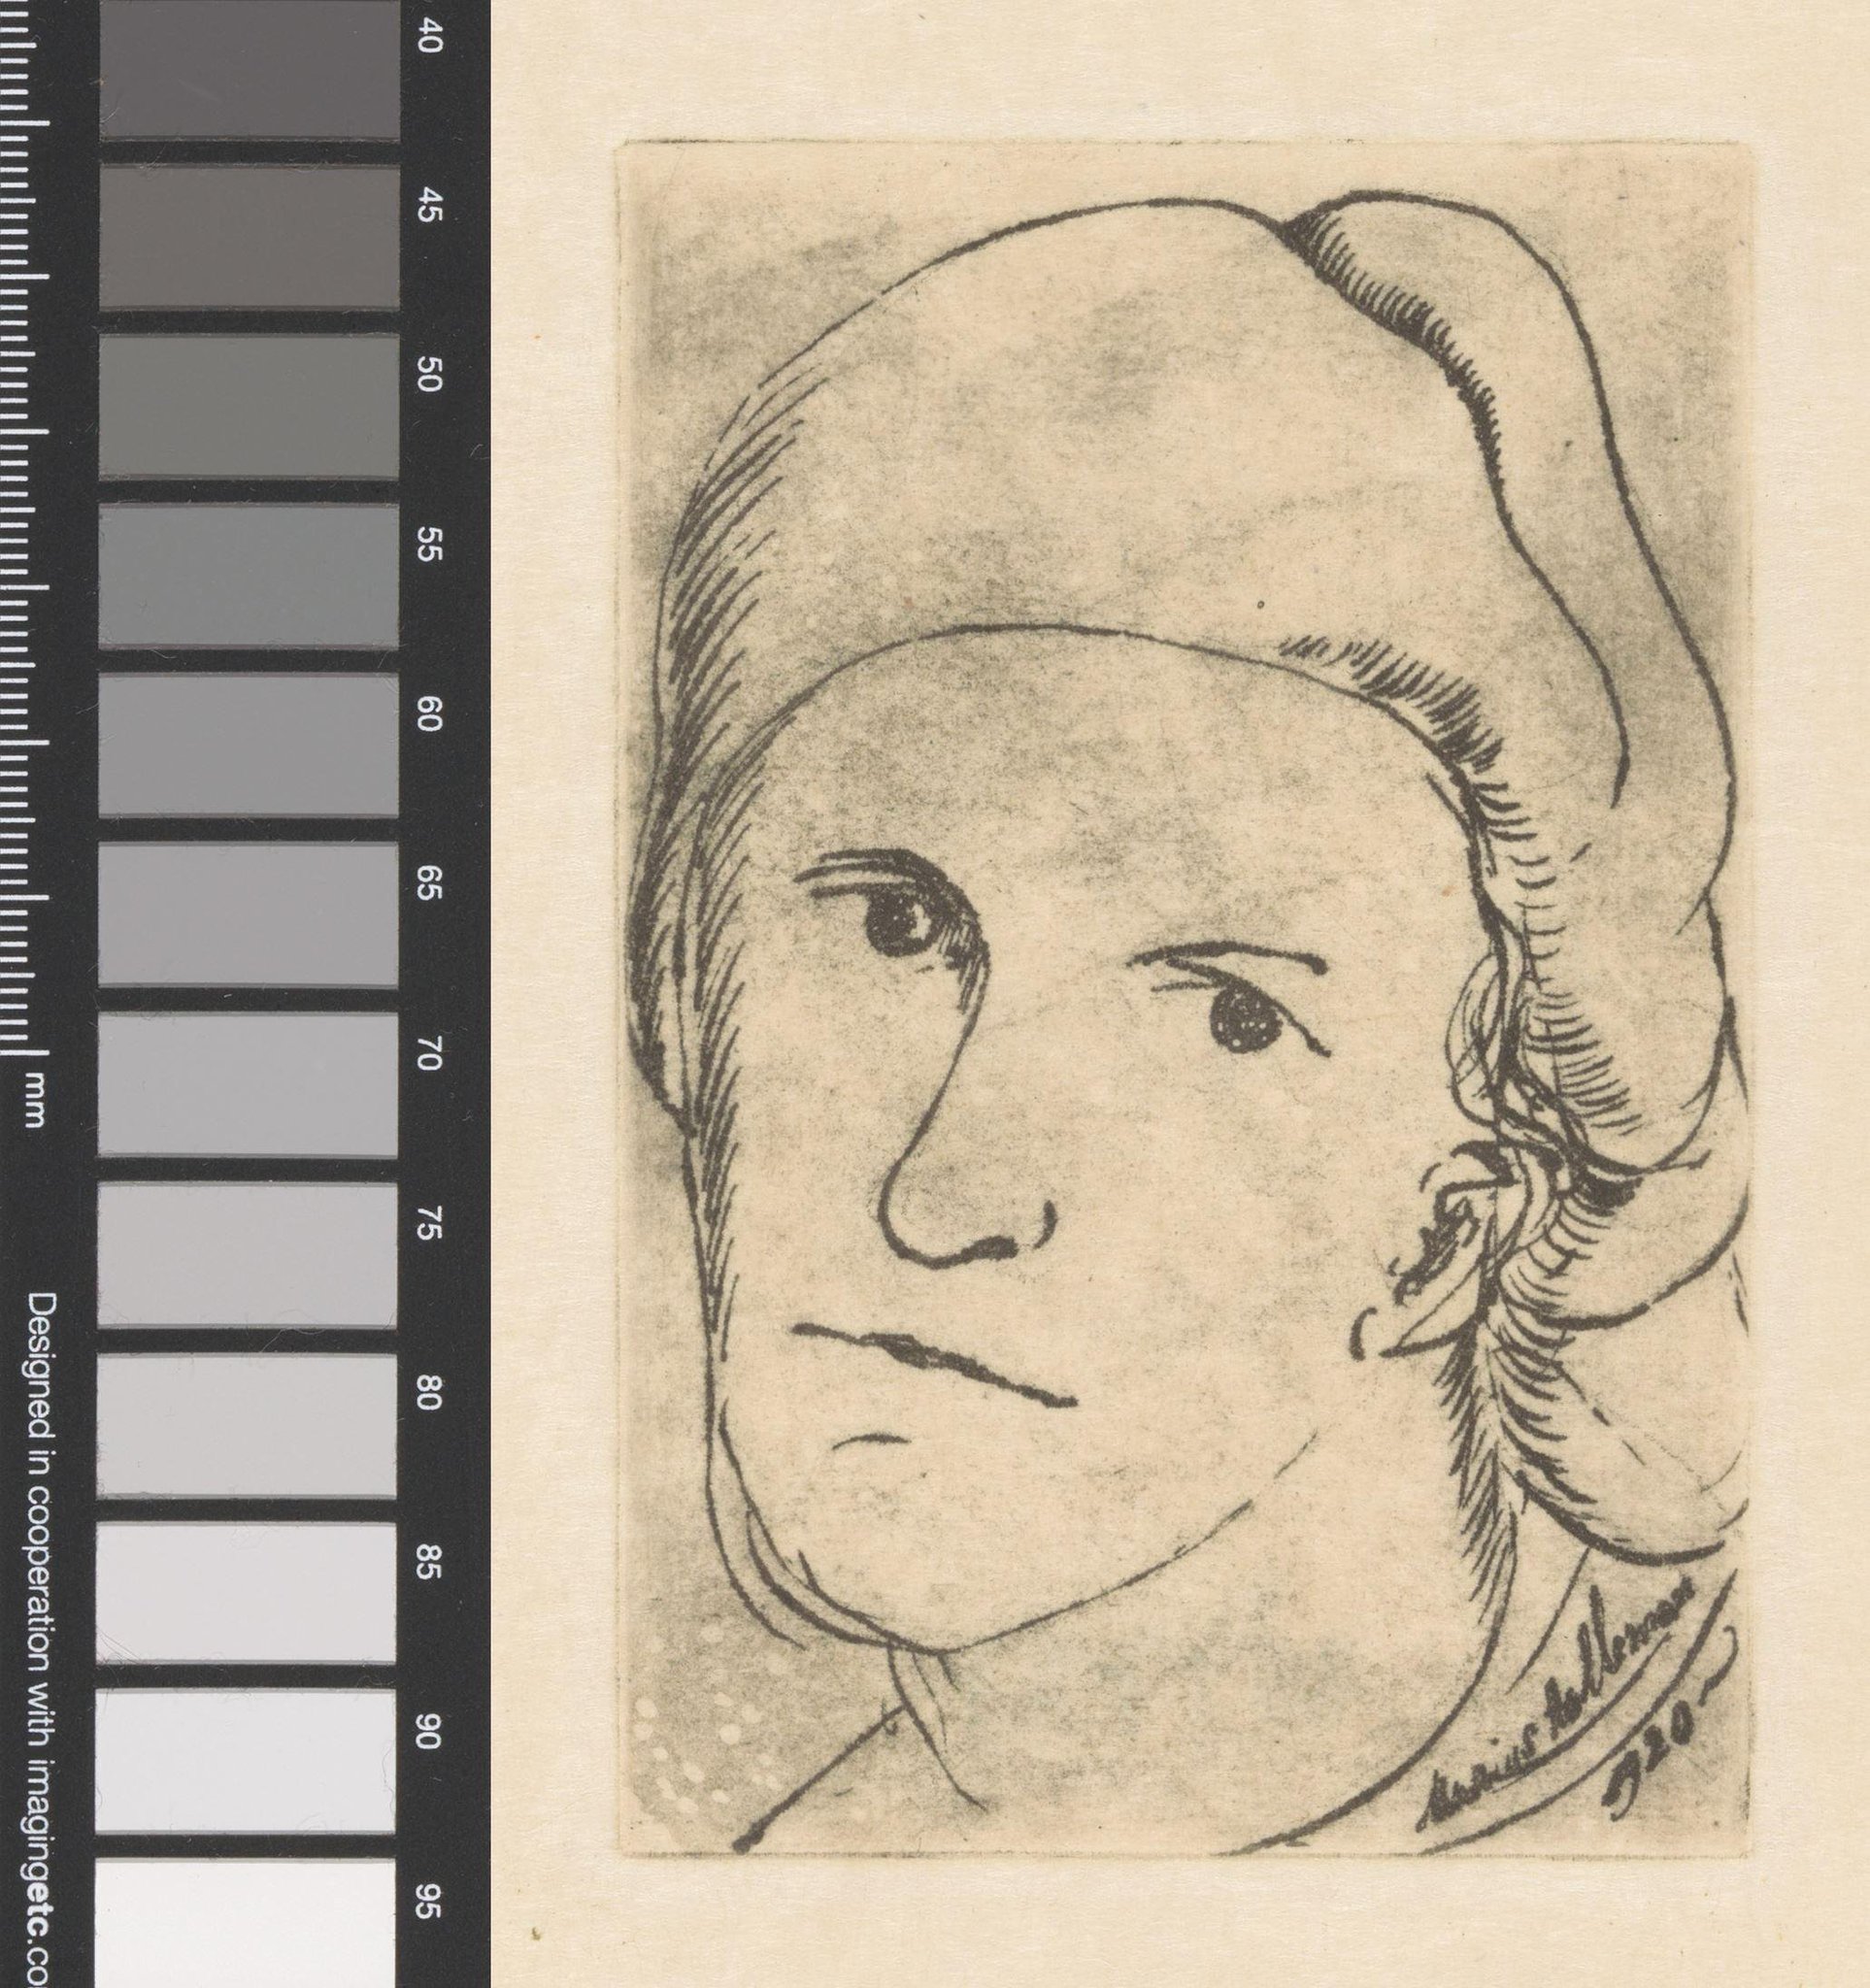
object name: print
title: Figuur met muts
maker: marius holleman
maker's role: draughtsman, print maker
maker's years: 1878-1926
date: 1920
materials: paper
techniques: etching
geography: groningen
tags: head-gear: hat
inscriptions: collector's mark: Lugt 2228